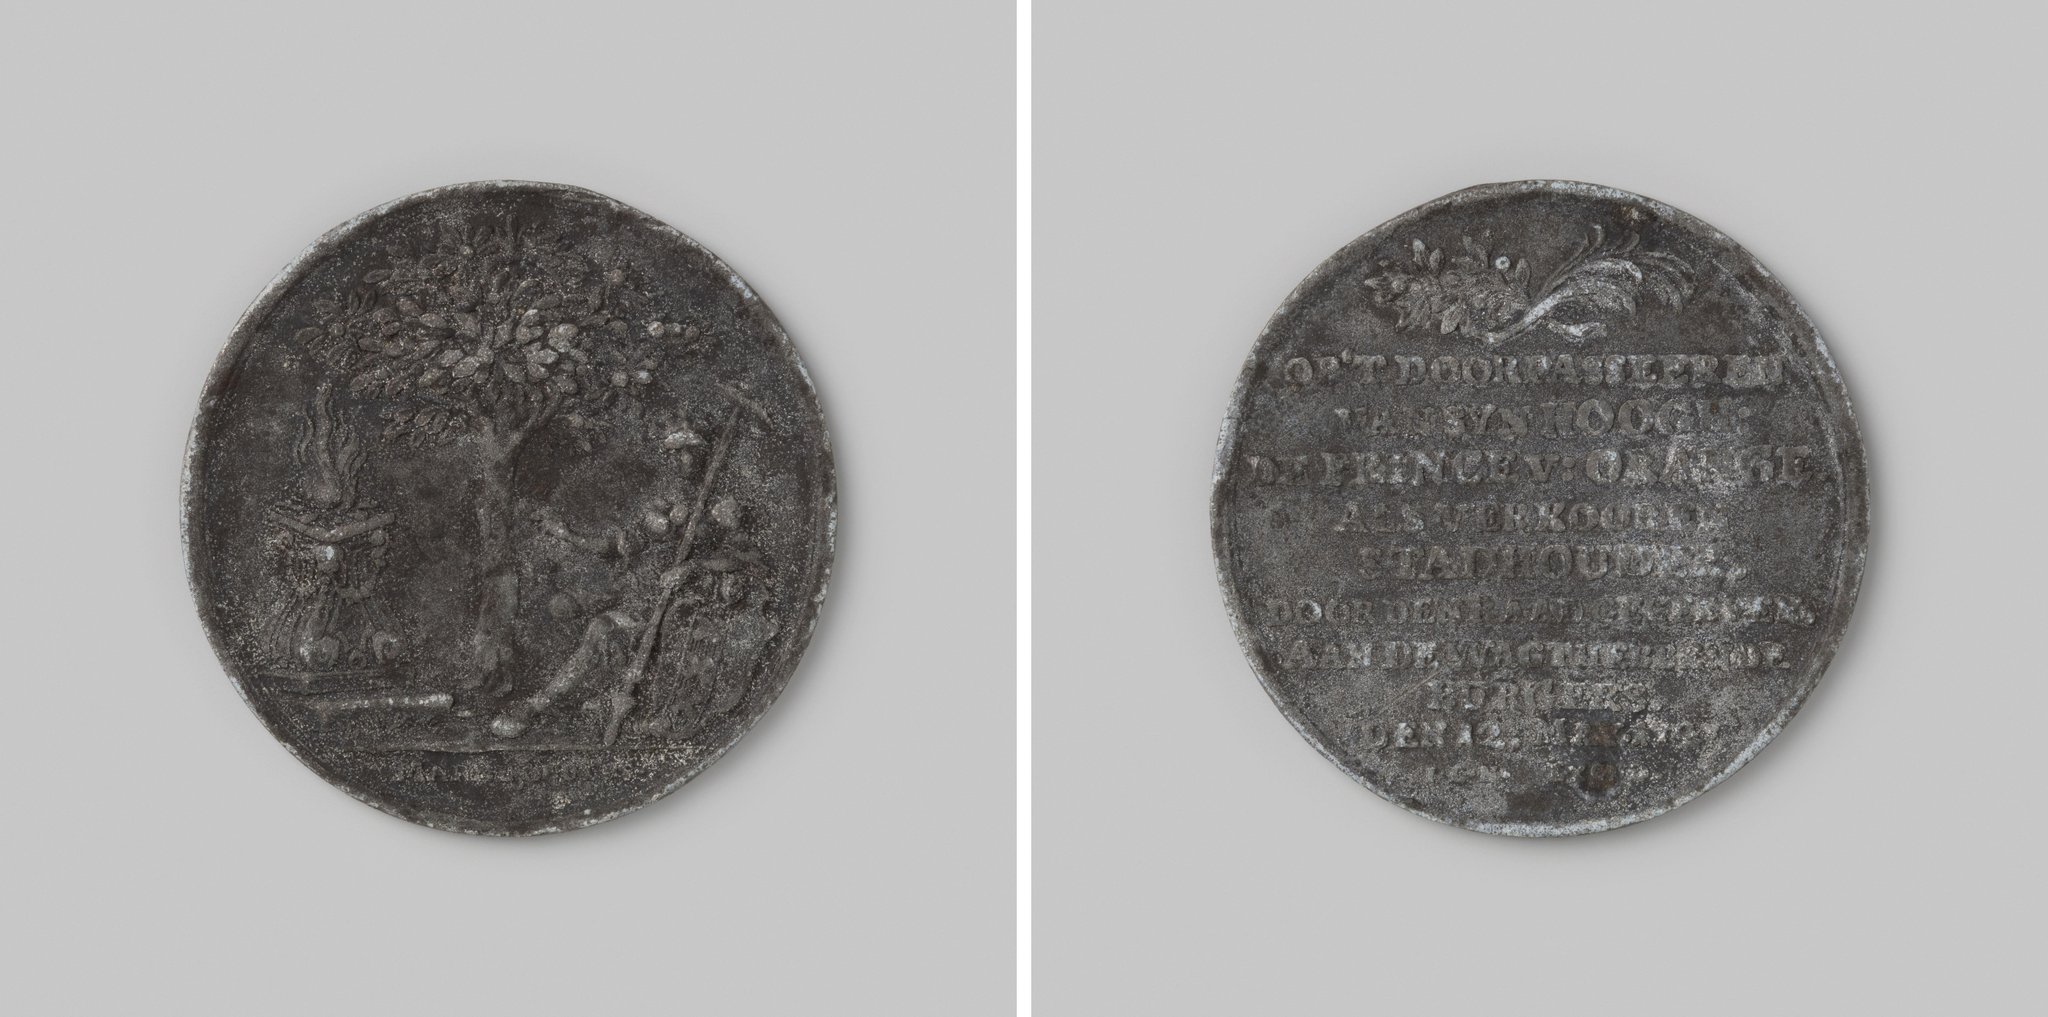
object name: history medal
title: Penning voor de burgerwacht bij het bezoek van Willem IV aan Amsterdam 1747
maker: johann conrad marmé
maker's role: die cutter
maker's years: 1710-1772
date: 1747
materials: tin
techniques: casting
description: Tinnen penning, op de voorzijde Amsterdam als Minerva tronend naast een oranjeboom en een brandend altaar, met afsnedetekst, op de keerzijde tien regels tekst onder lauwer- en palmtakken.